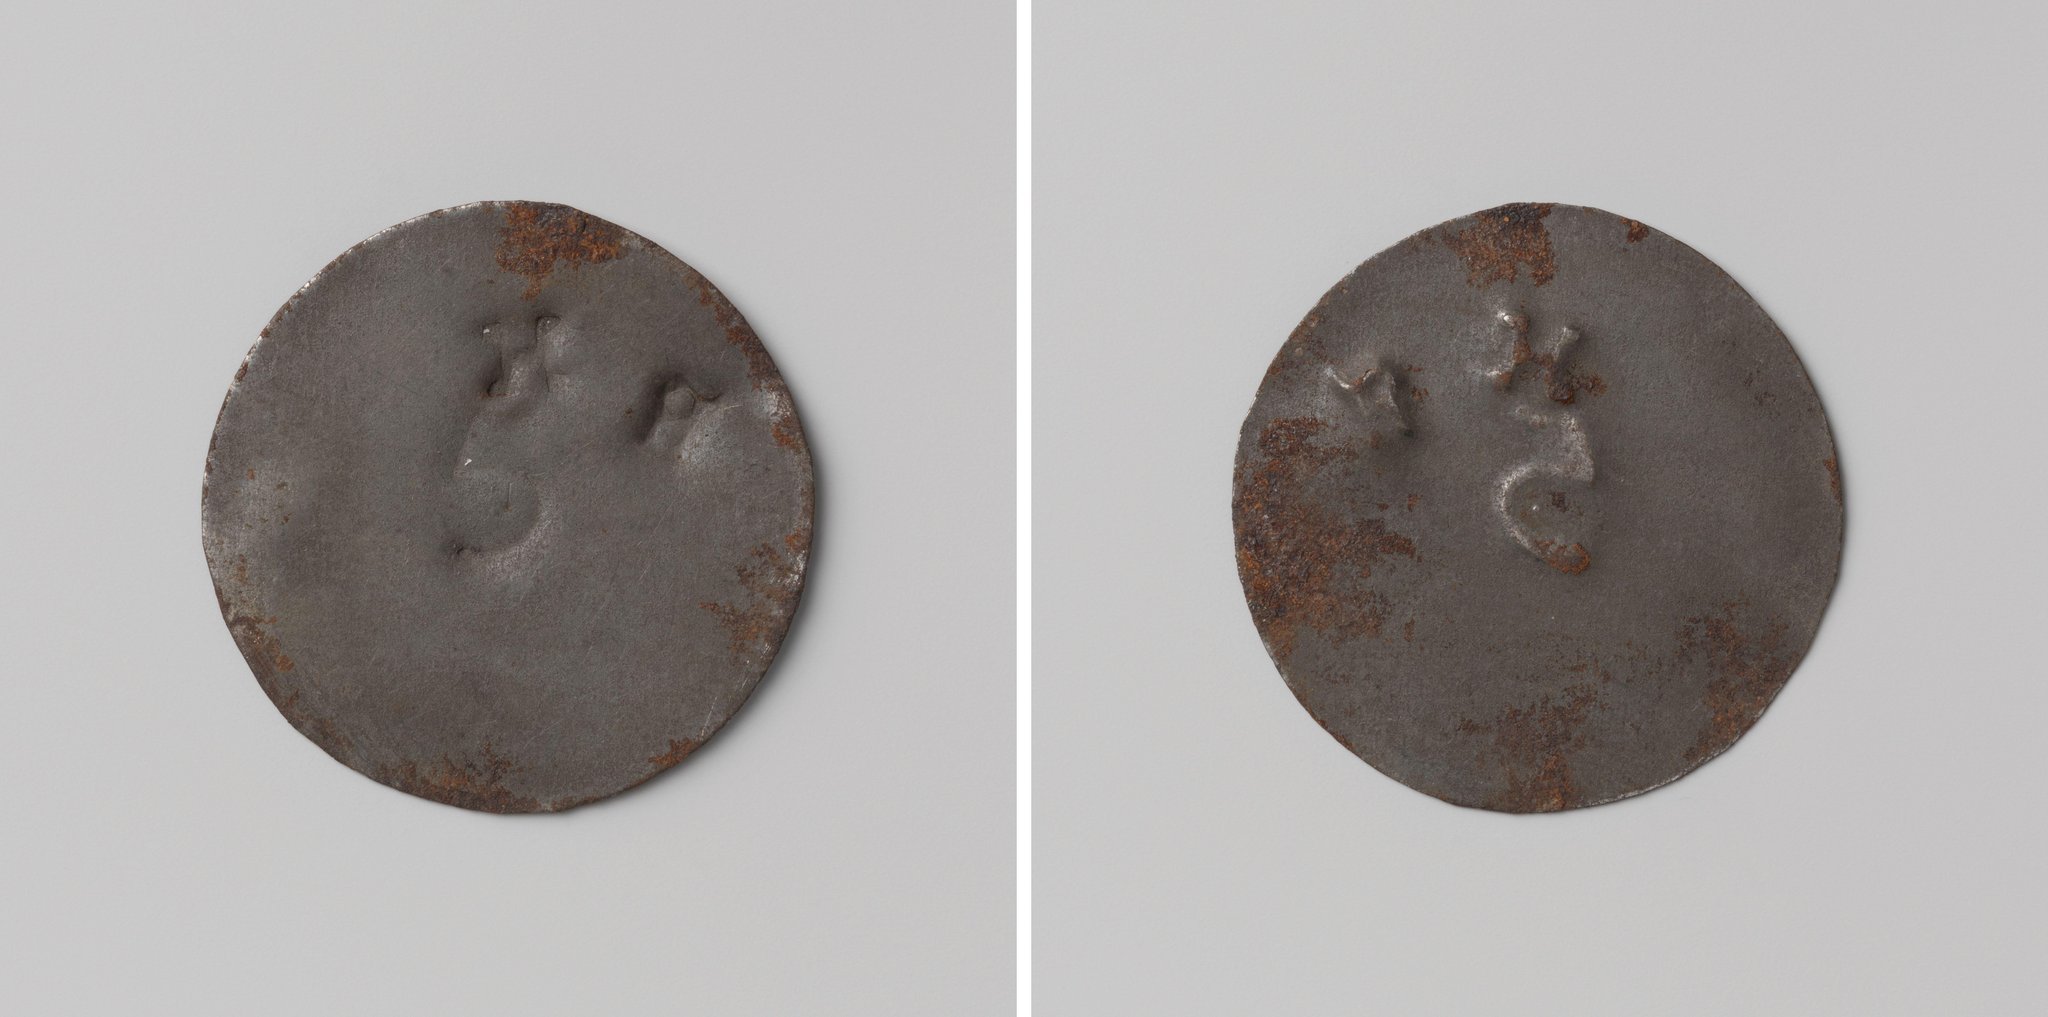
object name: huismunt prison money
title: Strafgevangenis Ommerschans of correctiehuis Sint Bernhard?, huismunt ter waarde van vijf cent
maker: Anonymous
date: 1822-1830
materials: metal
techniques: striking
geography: ommerschans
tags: maatschappij van weldadigheid, ommerschans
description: Eenzijdige munt. Voorzijde: twee merken boven waardeaanduiding binnen parelrand. Keerzijde: blanco.